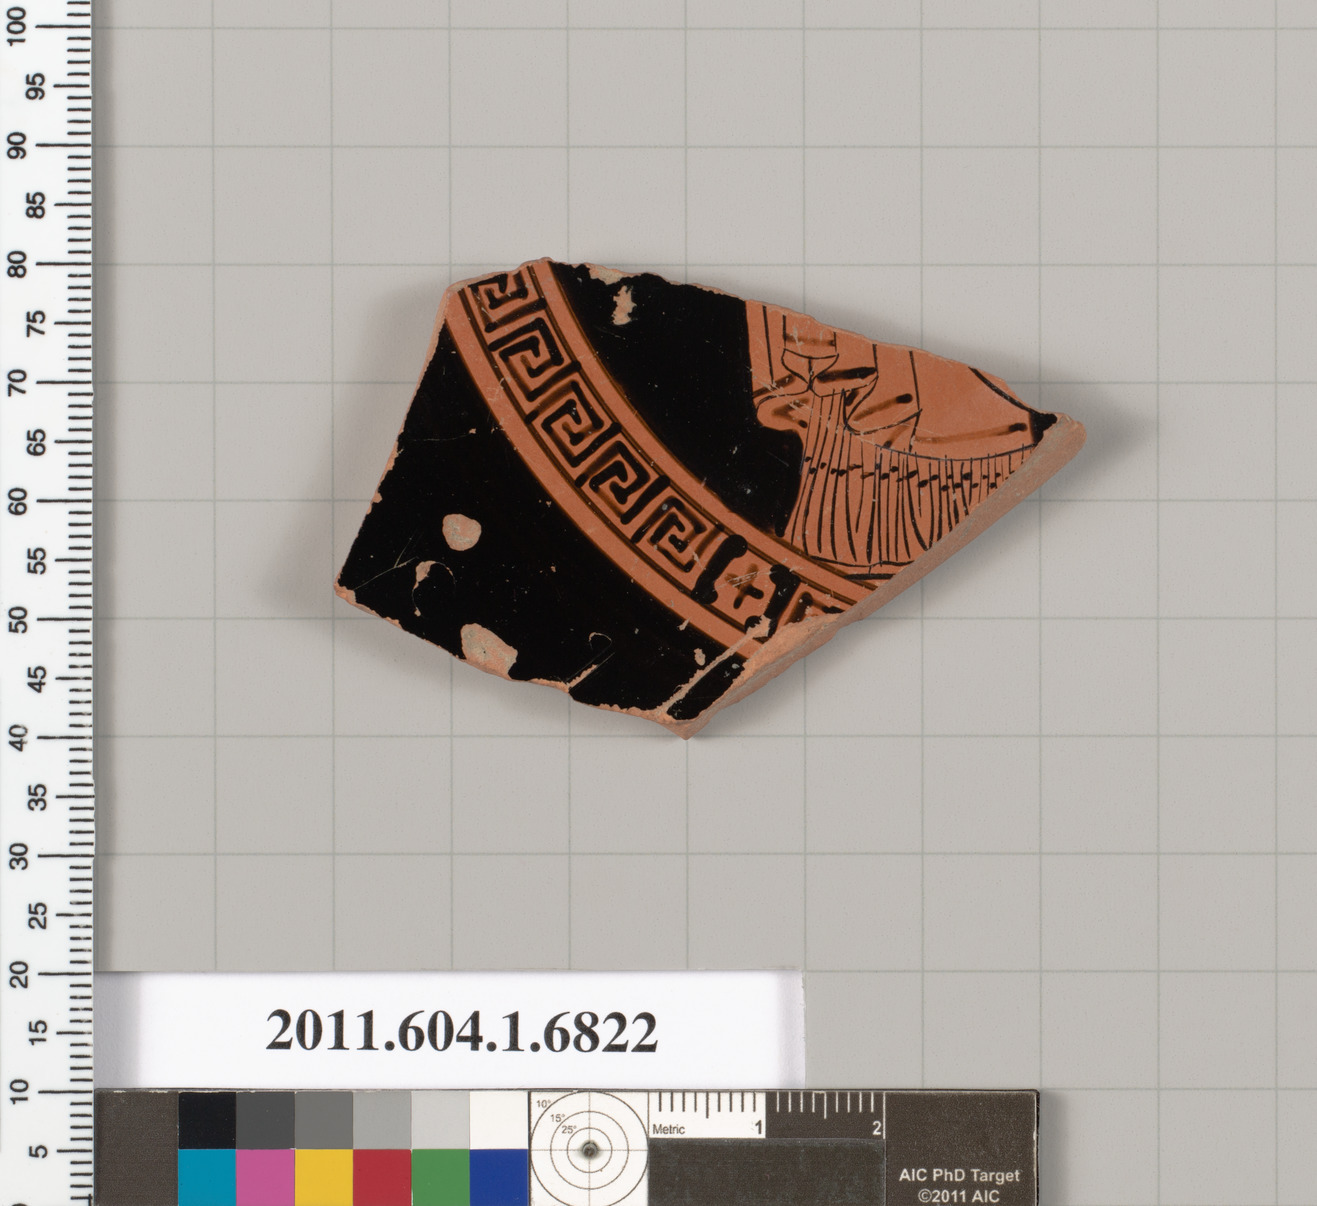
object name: kylix fragment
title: Terracotta fragment of a kylix (drinking cup)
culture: greek, attic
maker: painter of louvre g 265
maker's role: artist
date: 475-451 BCE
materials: terracotta